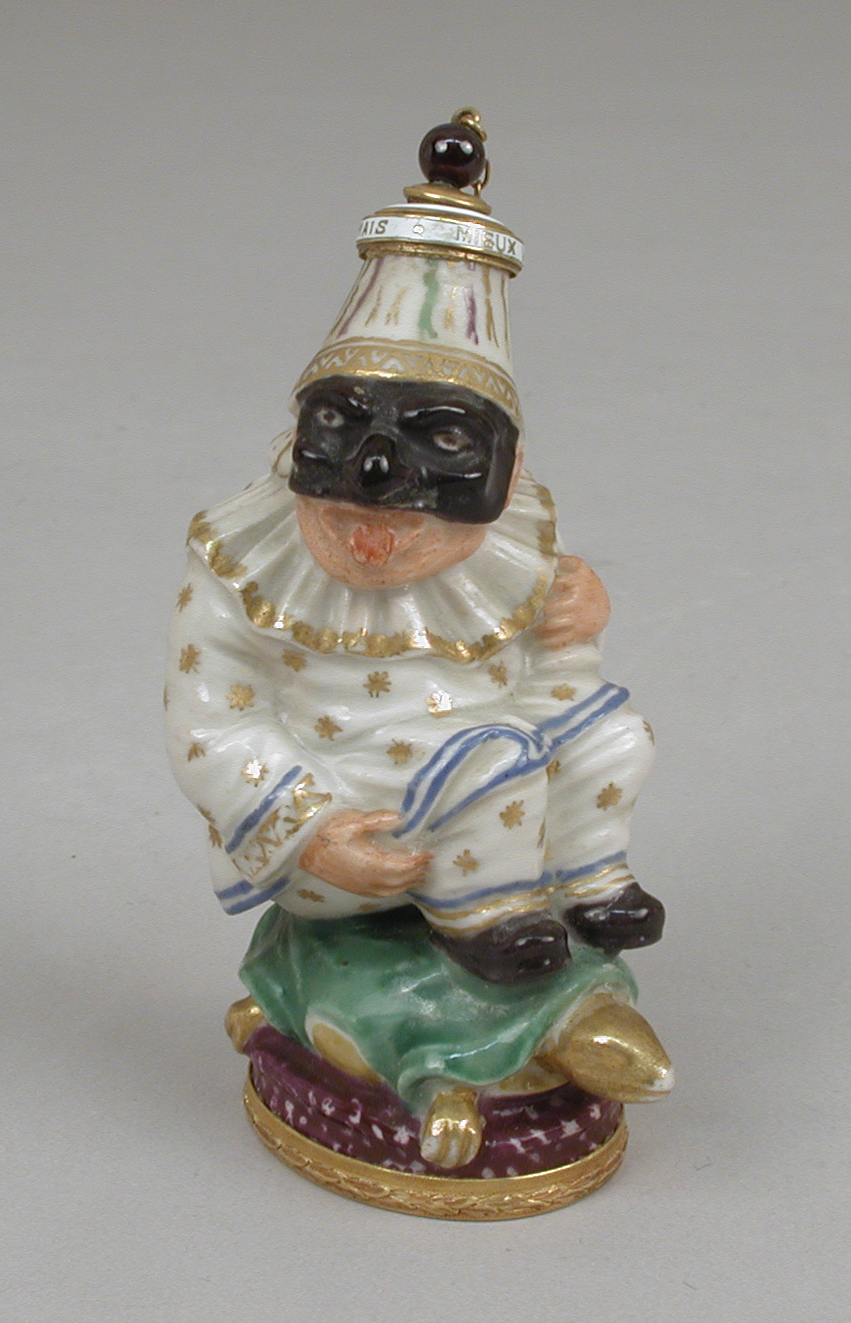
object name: scent bottle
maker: capodimonte porcelain manufactory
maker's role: manufactory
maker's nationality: italian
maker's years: 1740-1759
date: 1750-1755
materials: gold, soft paste porcelain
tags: masks,men,turtles,clowns